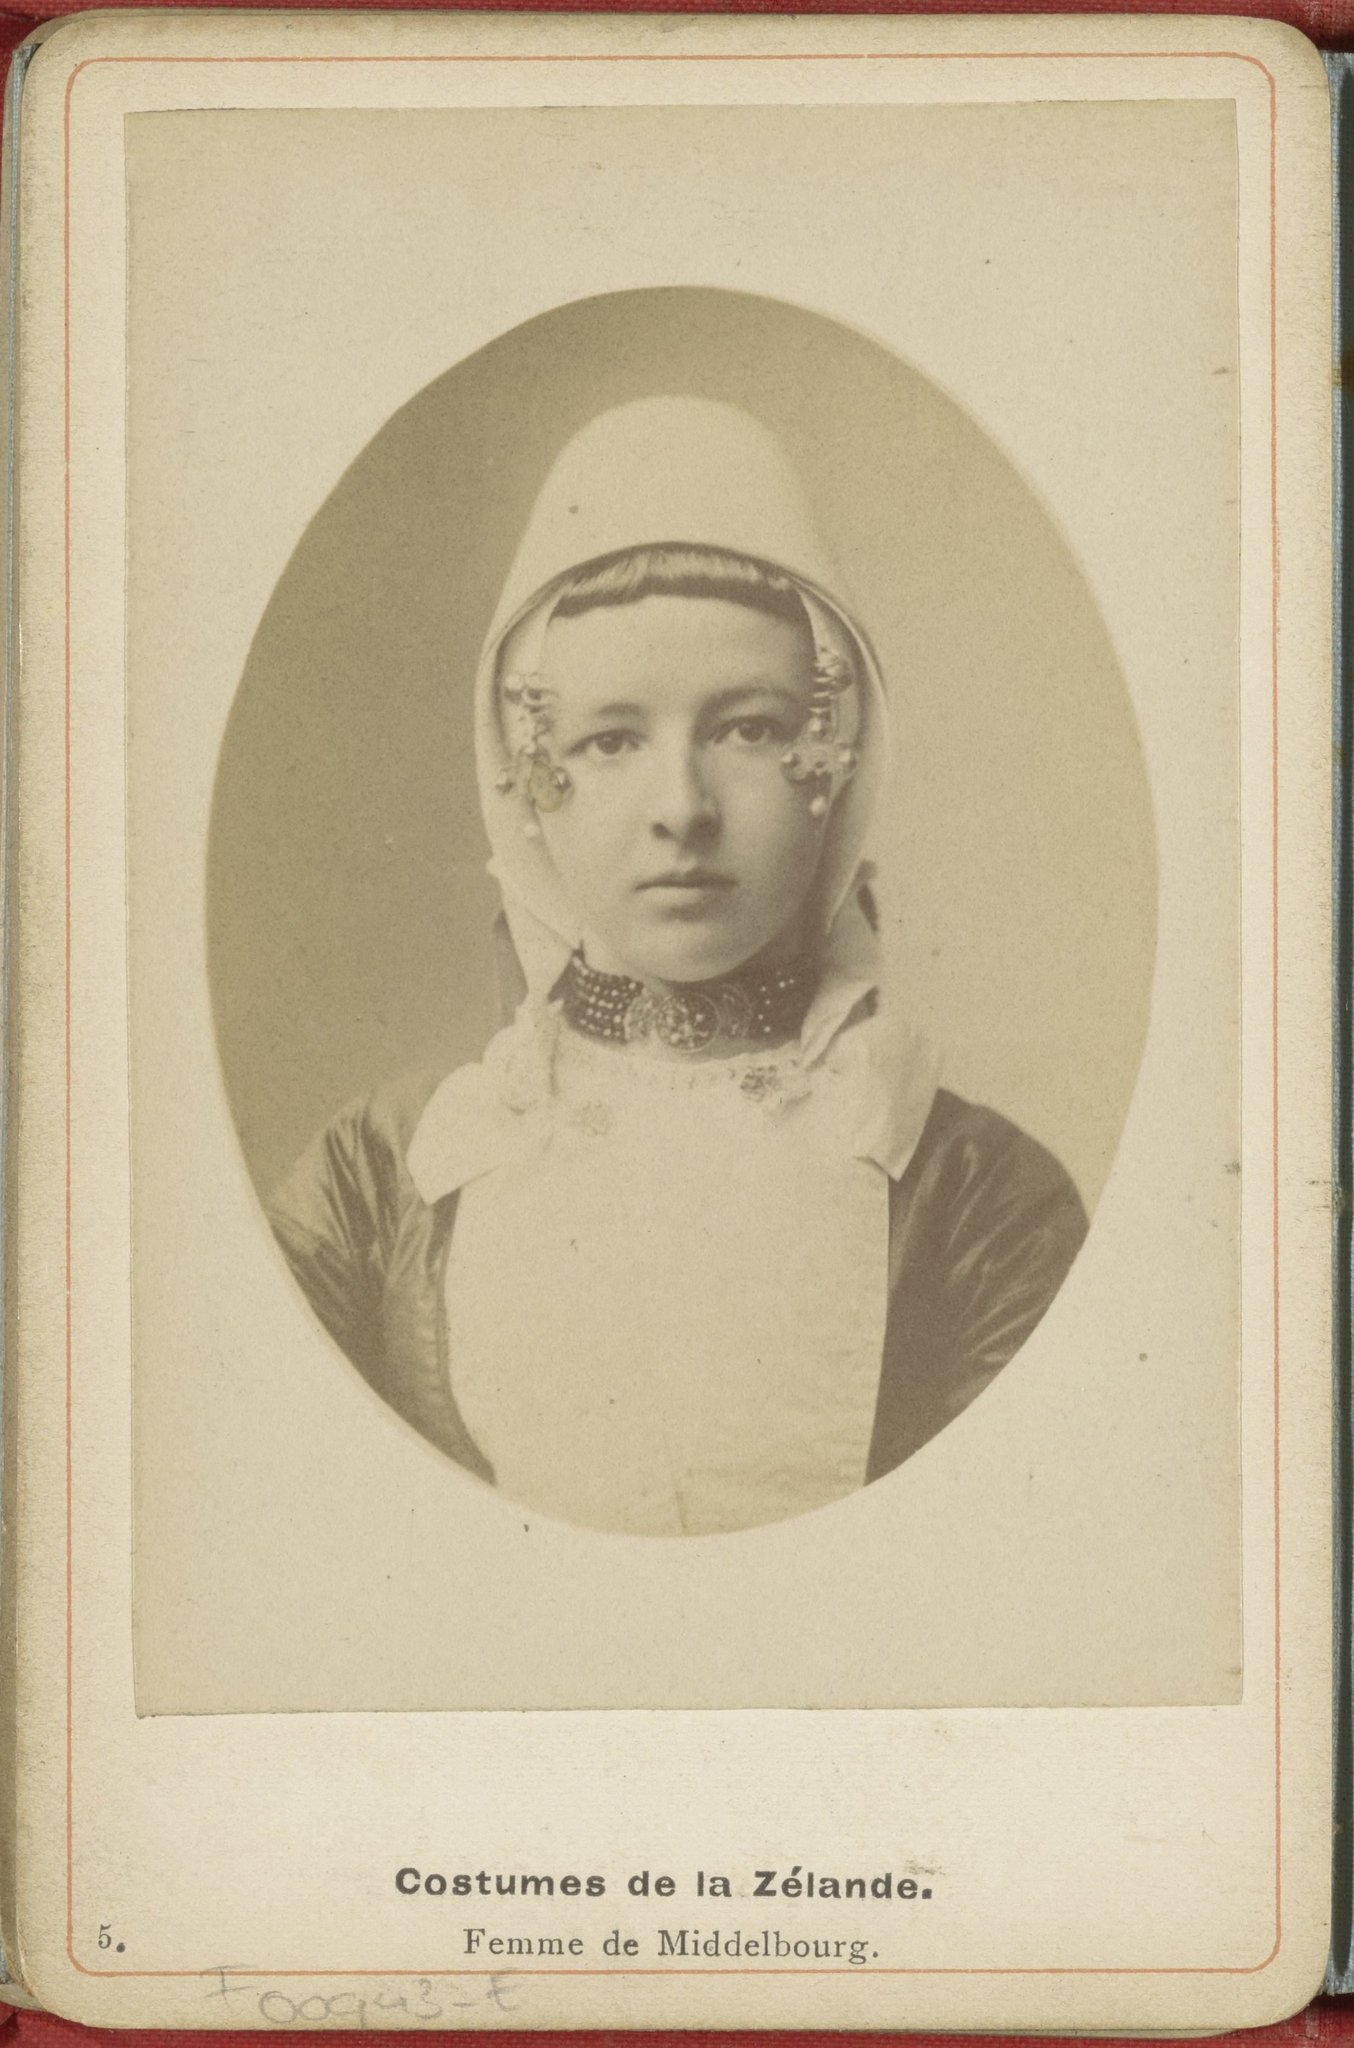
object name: photograph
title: Femme de Middelbourg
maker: Anonymous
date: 1870-1910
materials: cardboard, photographic support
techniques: albumen print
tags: folk costume, regional costume (+ women's clothes)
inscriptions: number: ‘5’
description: Onderdeel van Leporelloalbum met Zeeuwse klederdrachten.